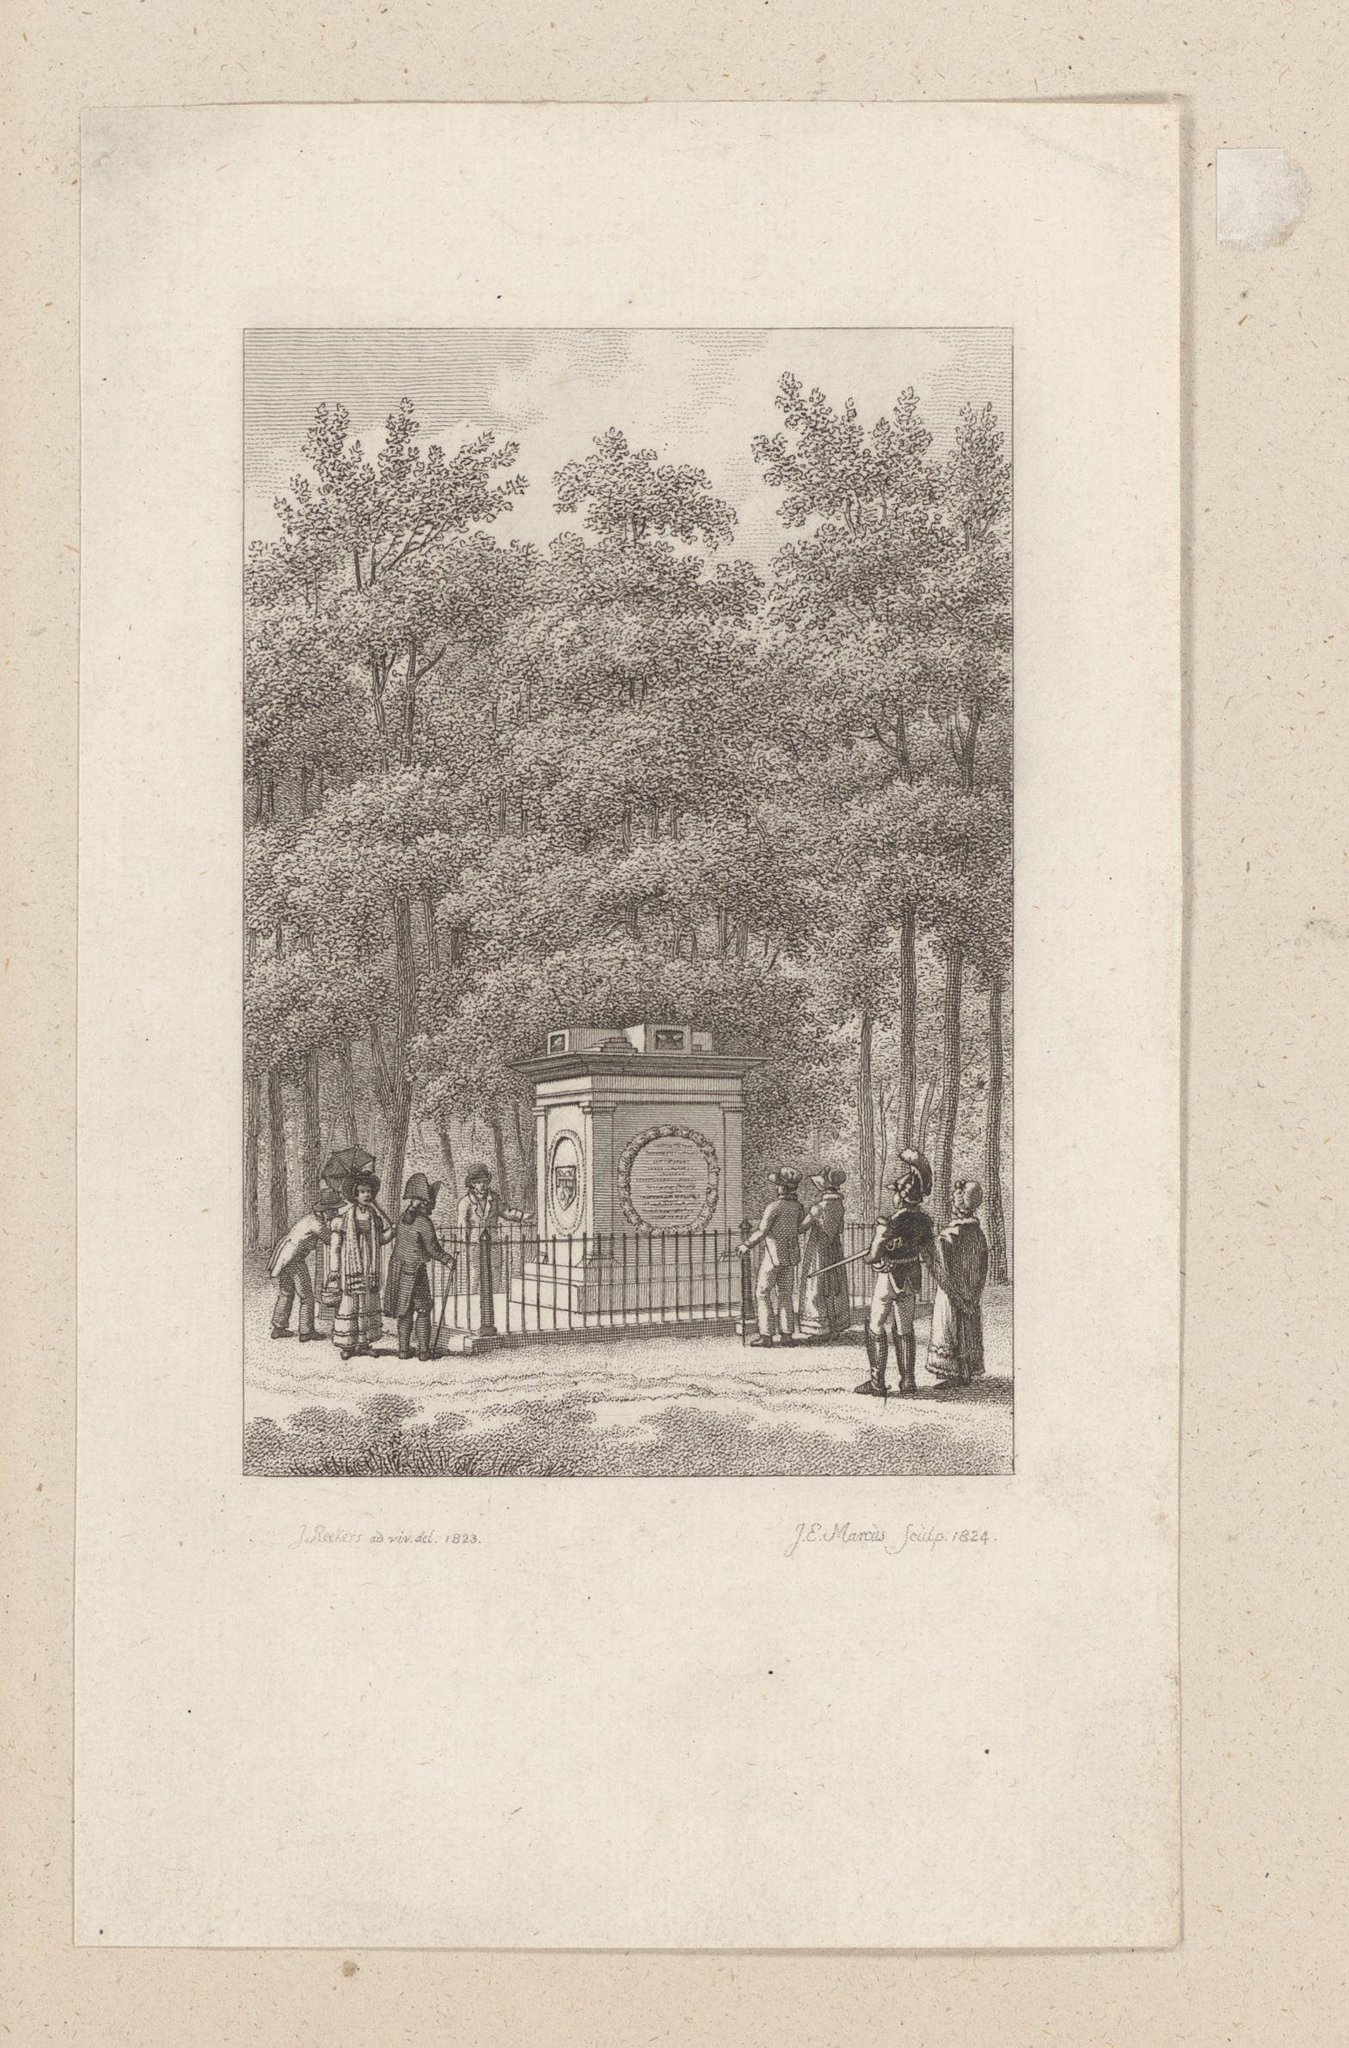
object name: print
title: Gedenksteen voor Coster bij 400-jarig jubileum uitvinding boekdrukkunst, 1823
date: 1824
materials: paper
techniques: engraving, etching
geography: netherlands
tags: haarlem, monument, statue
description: Monument opgericht voor Laurens Jansz. Coster in de Haarlemmerhout bij de viering van het 400-jarige jubileum op 10-11 juli in 1823 van de uitvinding boekdrukkunst. De prent maakt deel uit van een album.